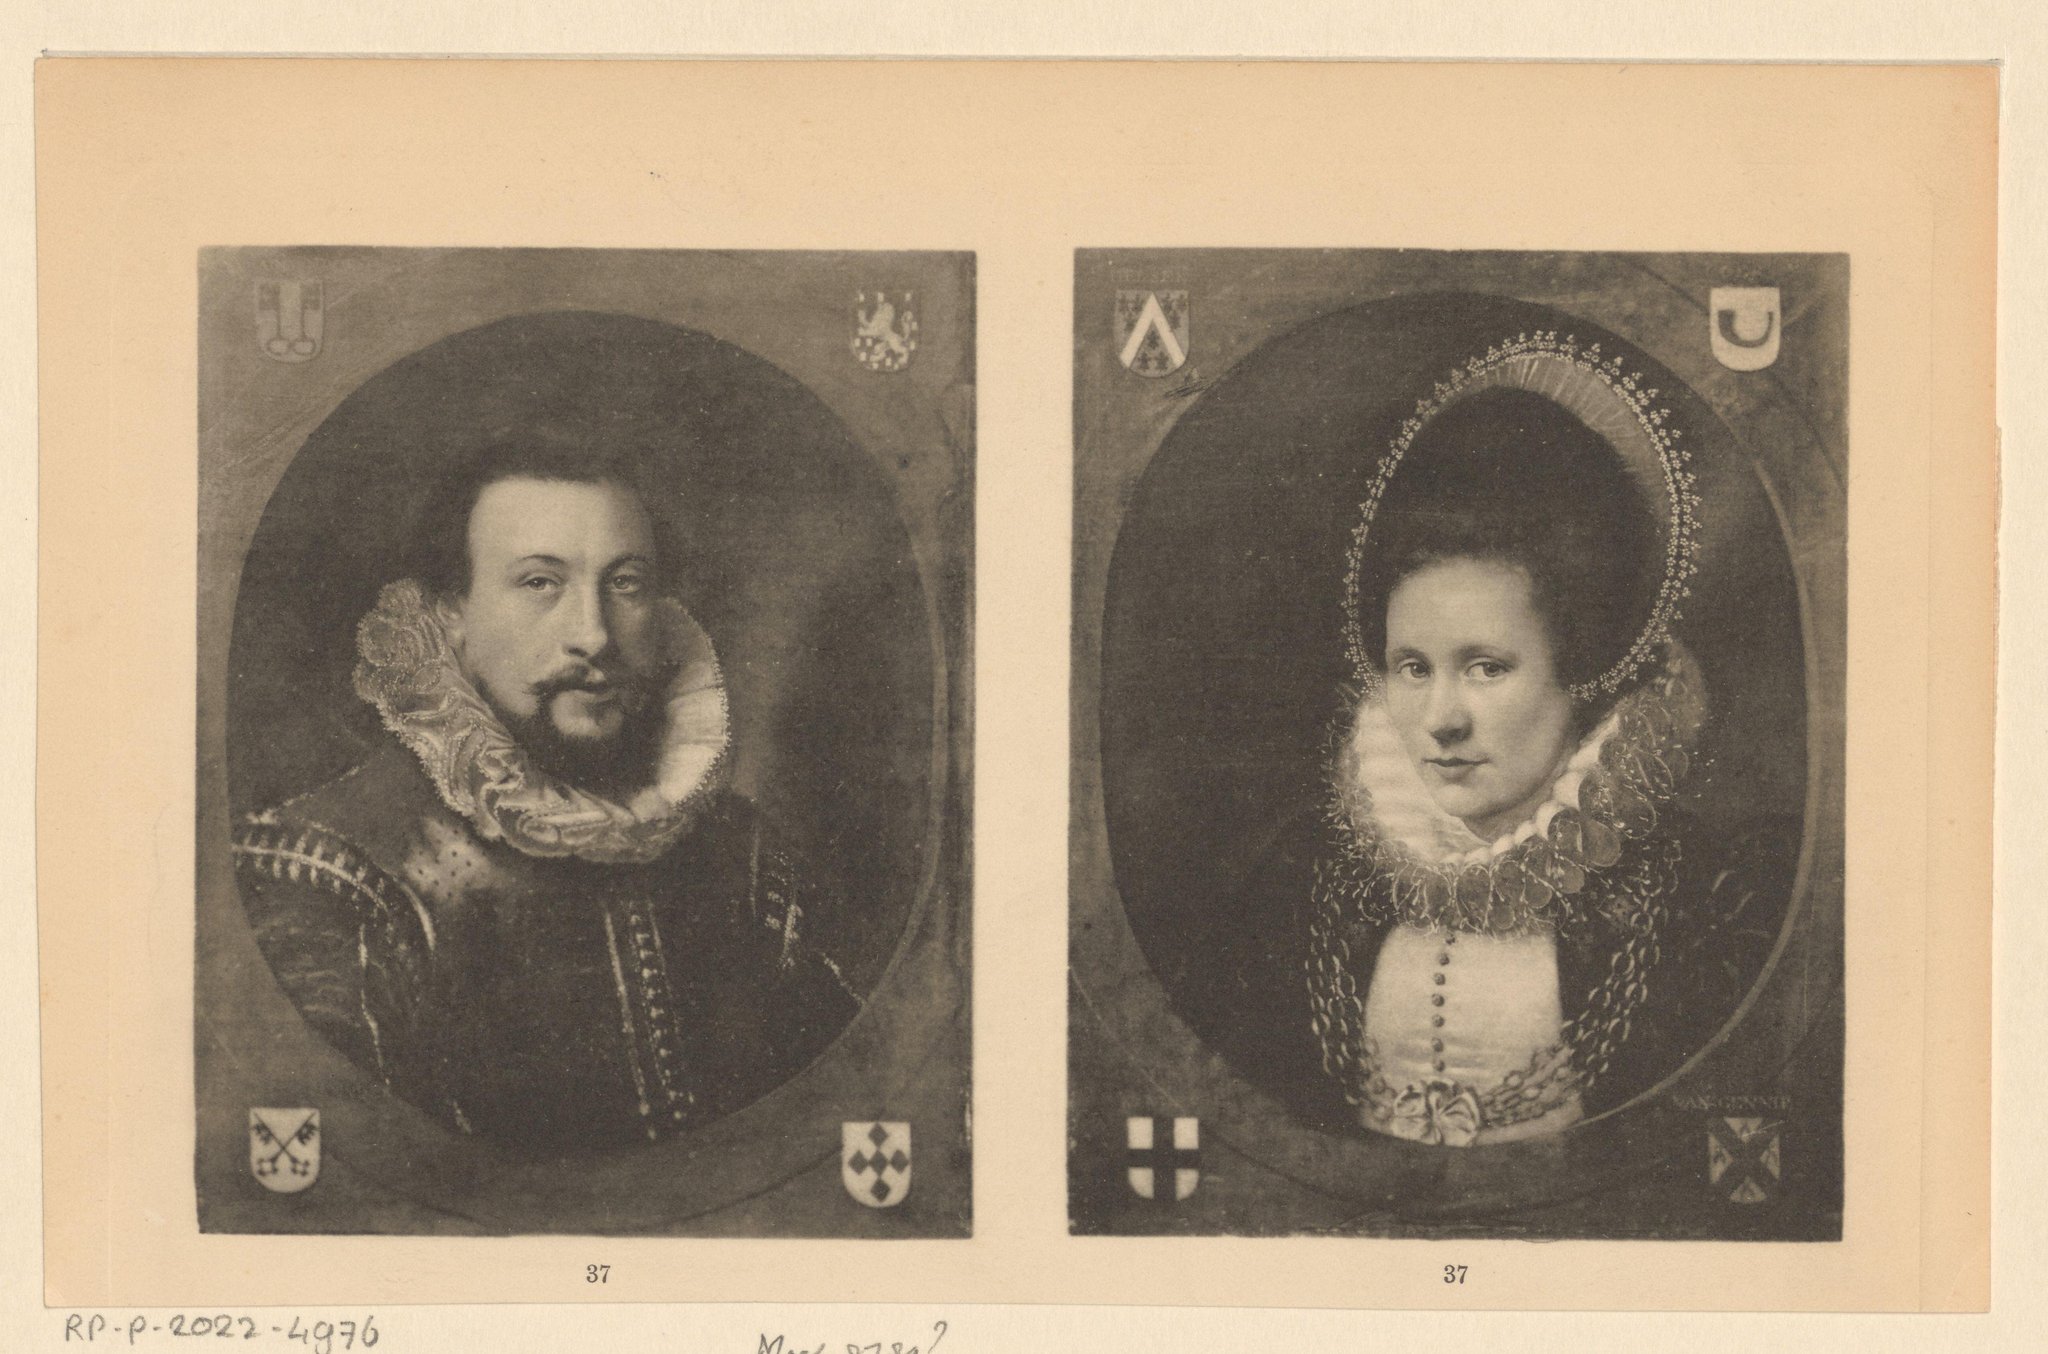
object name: photomechanical print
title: Portretten van een onbekende man genaamd Wachendorff en een onbekende vrouw genaamd Van Herzel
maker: Anonymous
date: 1900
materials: paper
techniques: blind stamped, photograph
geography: amsterdam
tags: historical persons not known by name - bb - woman, historical persons not known by name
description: Prent uit: veilingcatalogus Frederik Muller & Co. (24 april 1900), nr. 37.